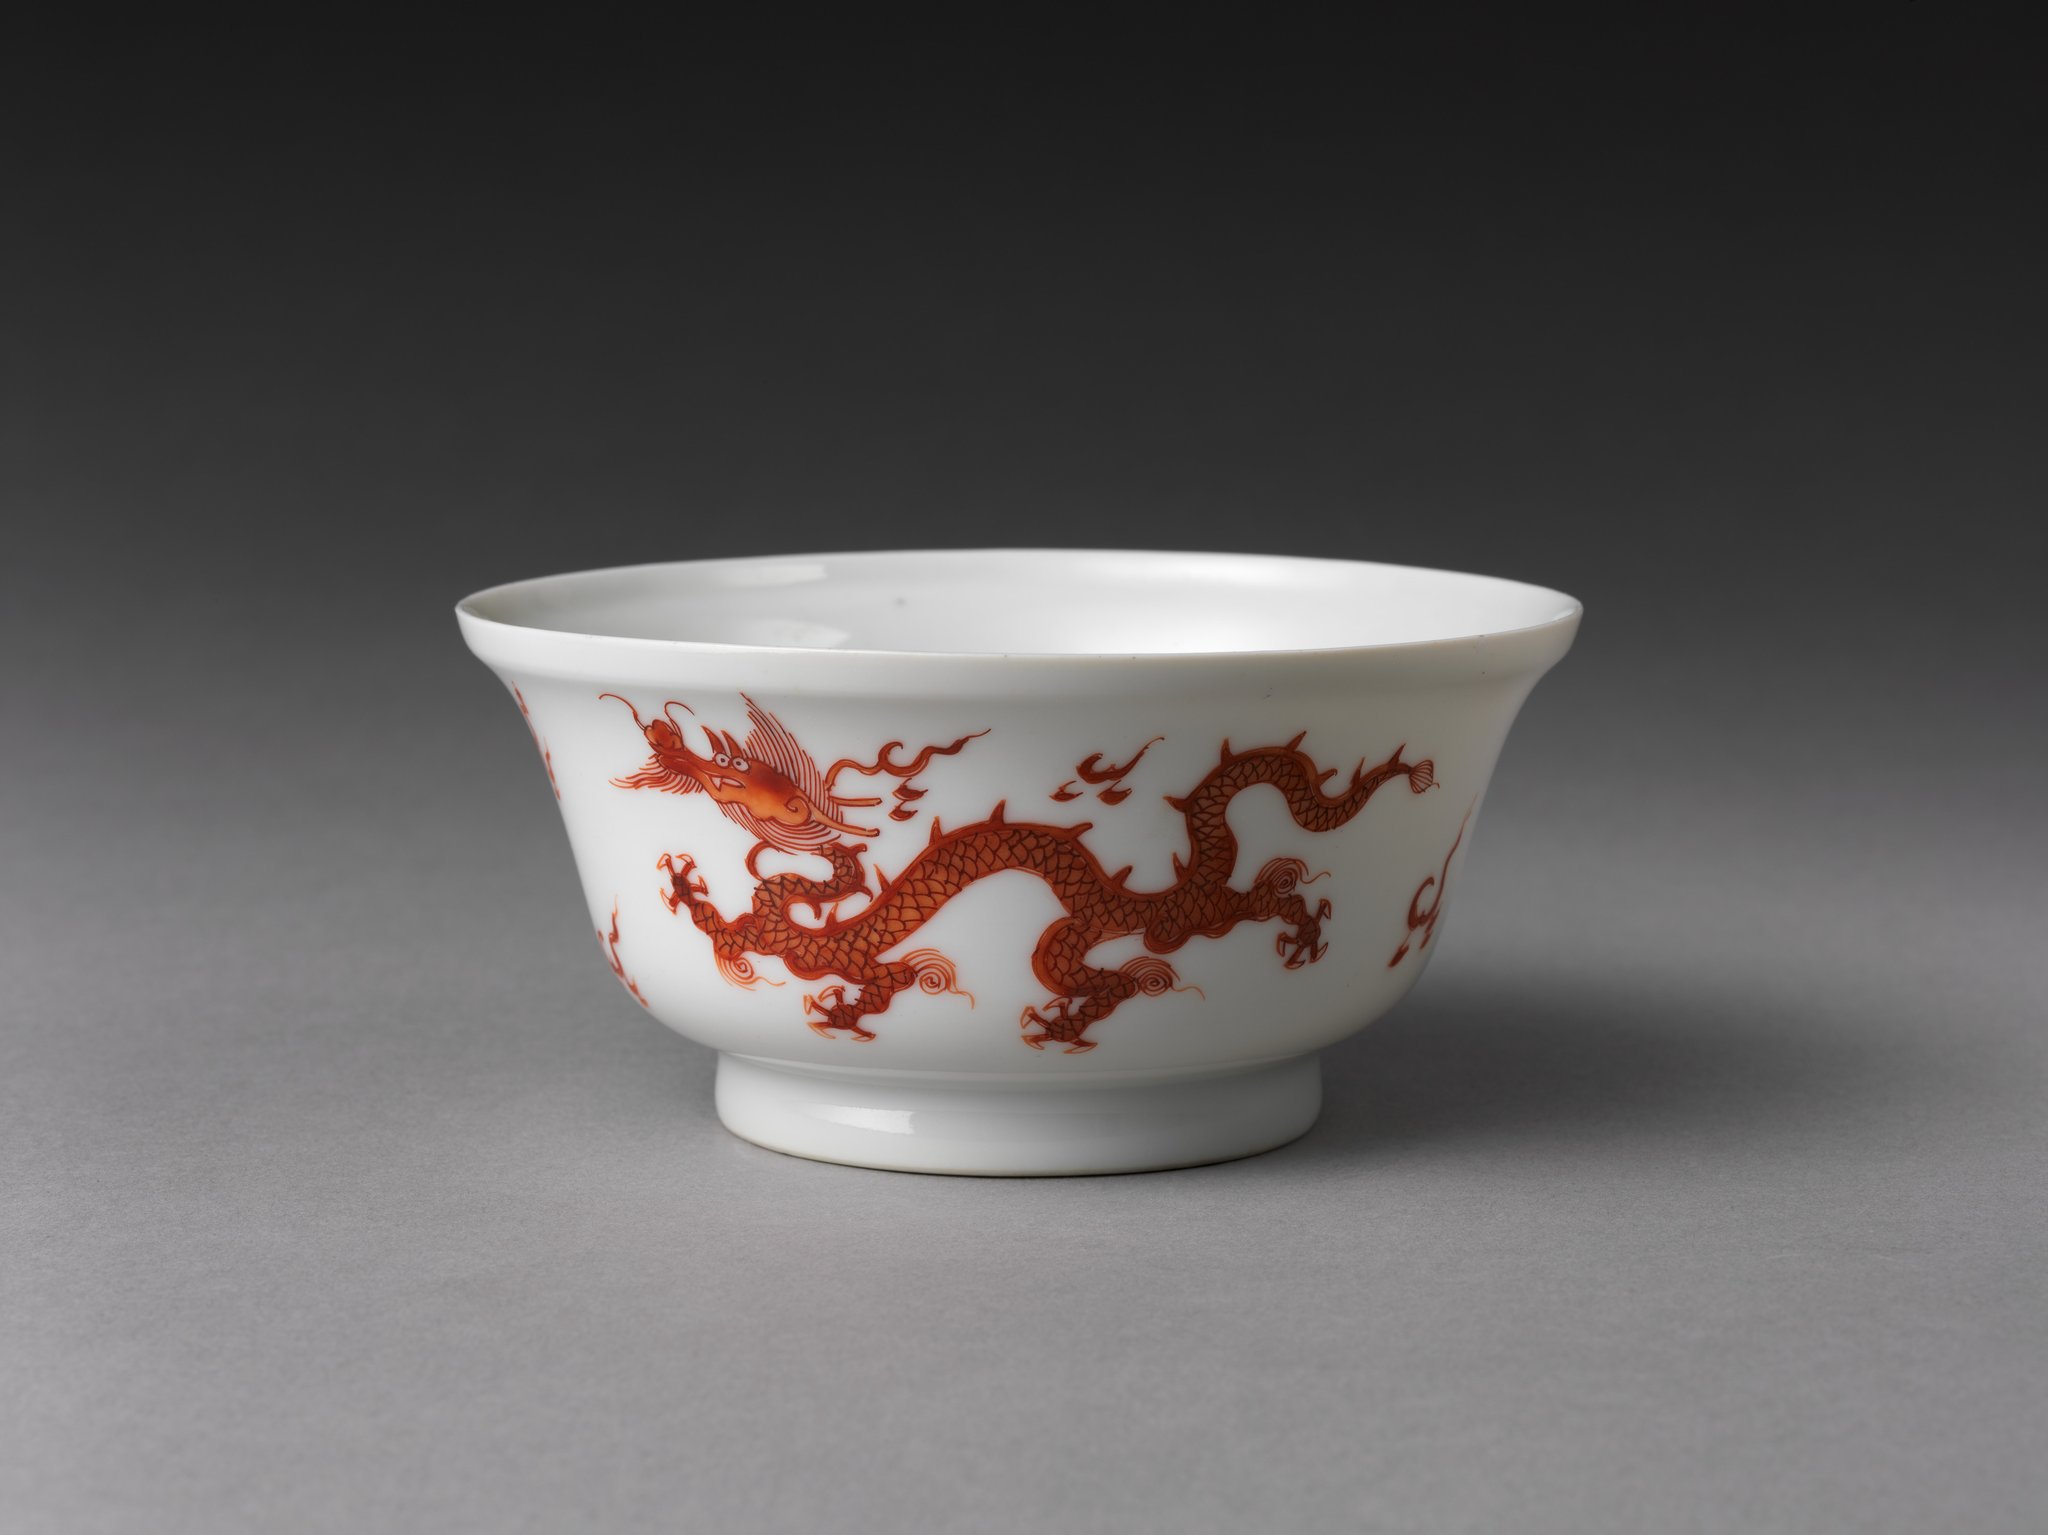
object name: bowl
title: Bowl with dragon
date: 1735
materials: enamel, glaze, hard paste porcelain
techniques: painting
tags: dragons